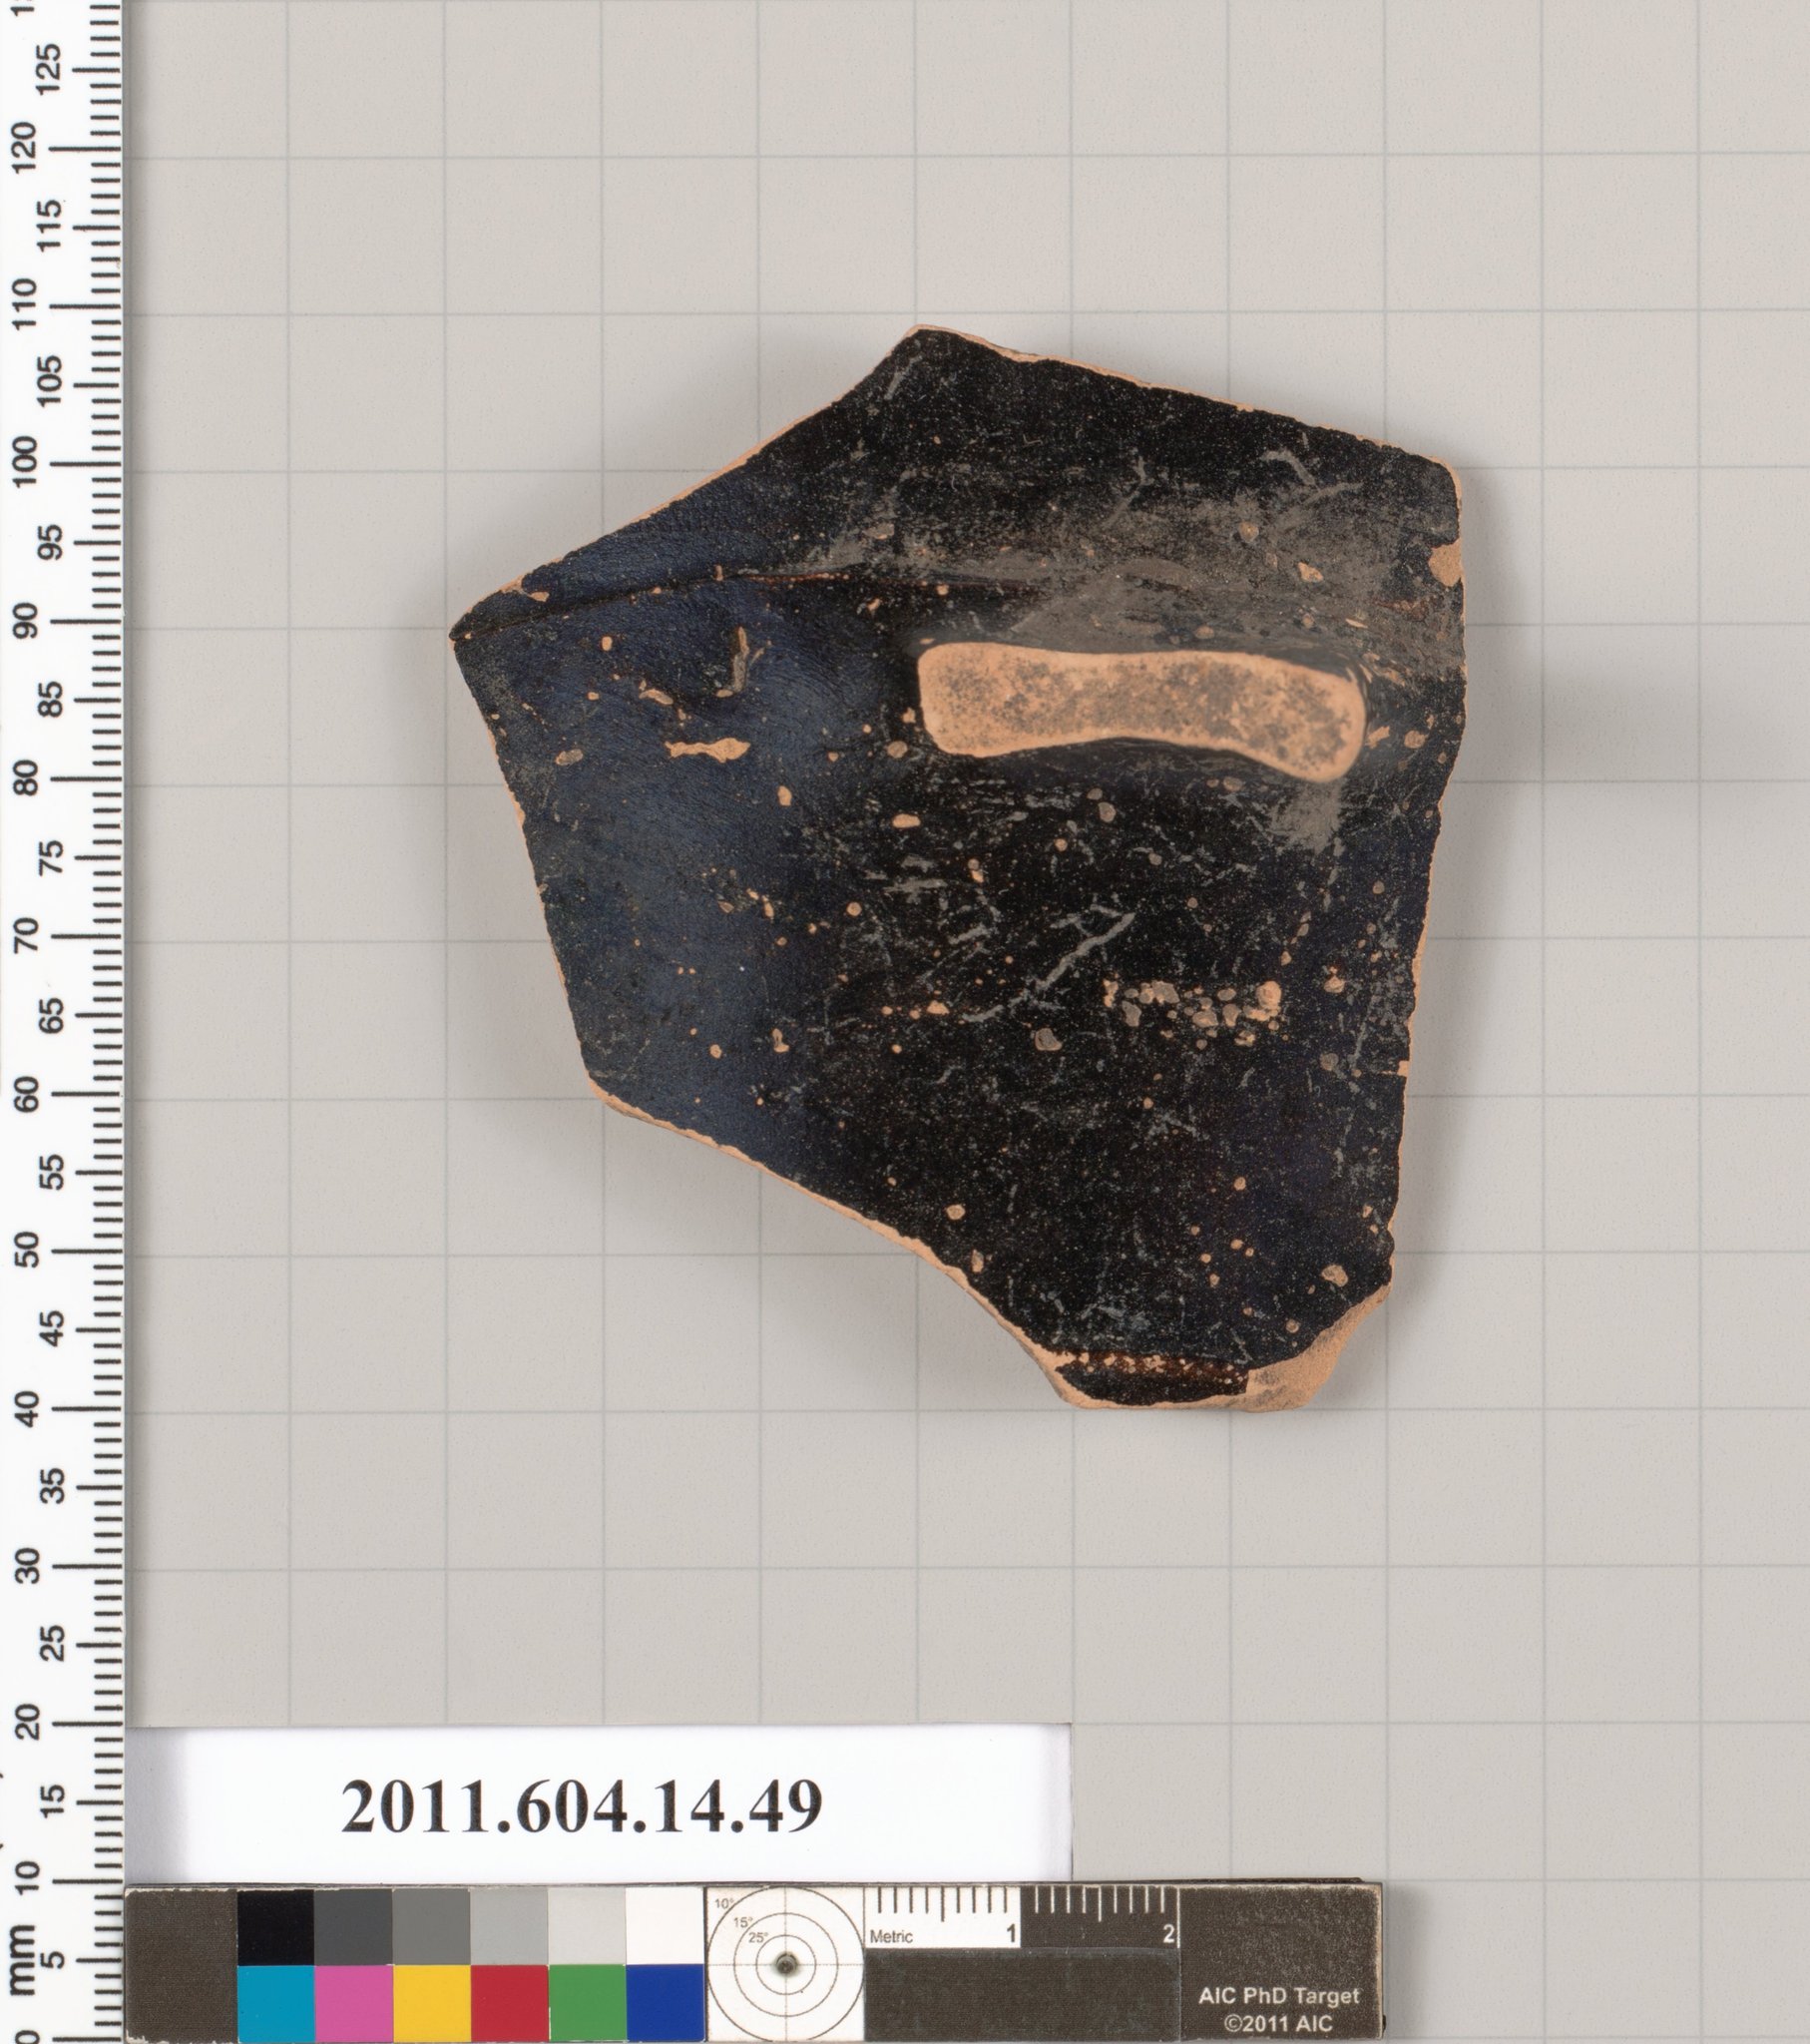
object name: undetermined closed shape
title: Terracotta fragment of a closed shape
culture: unknown fabric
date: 600-301 BCE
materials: terracotta